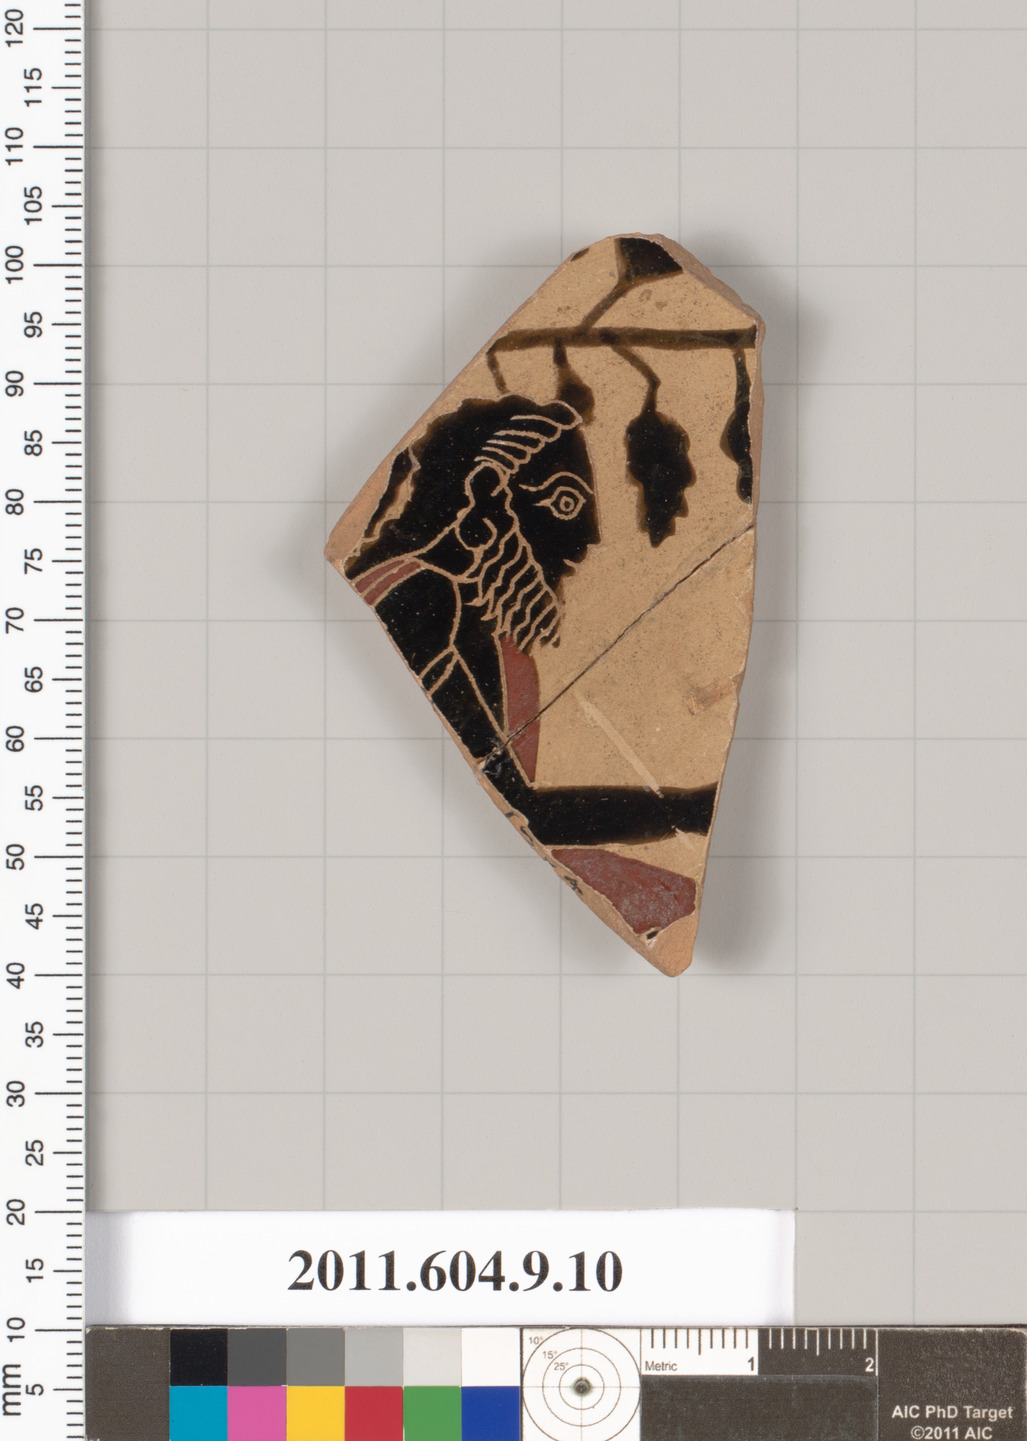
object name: kylix fragment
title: Terracotta fragment of a kylix (drinking cup)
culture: greek, laconian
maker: boreads painter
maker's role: artist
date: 575-551 BCE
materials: terracotta